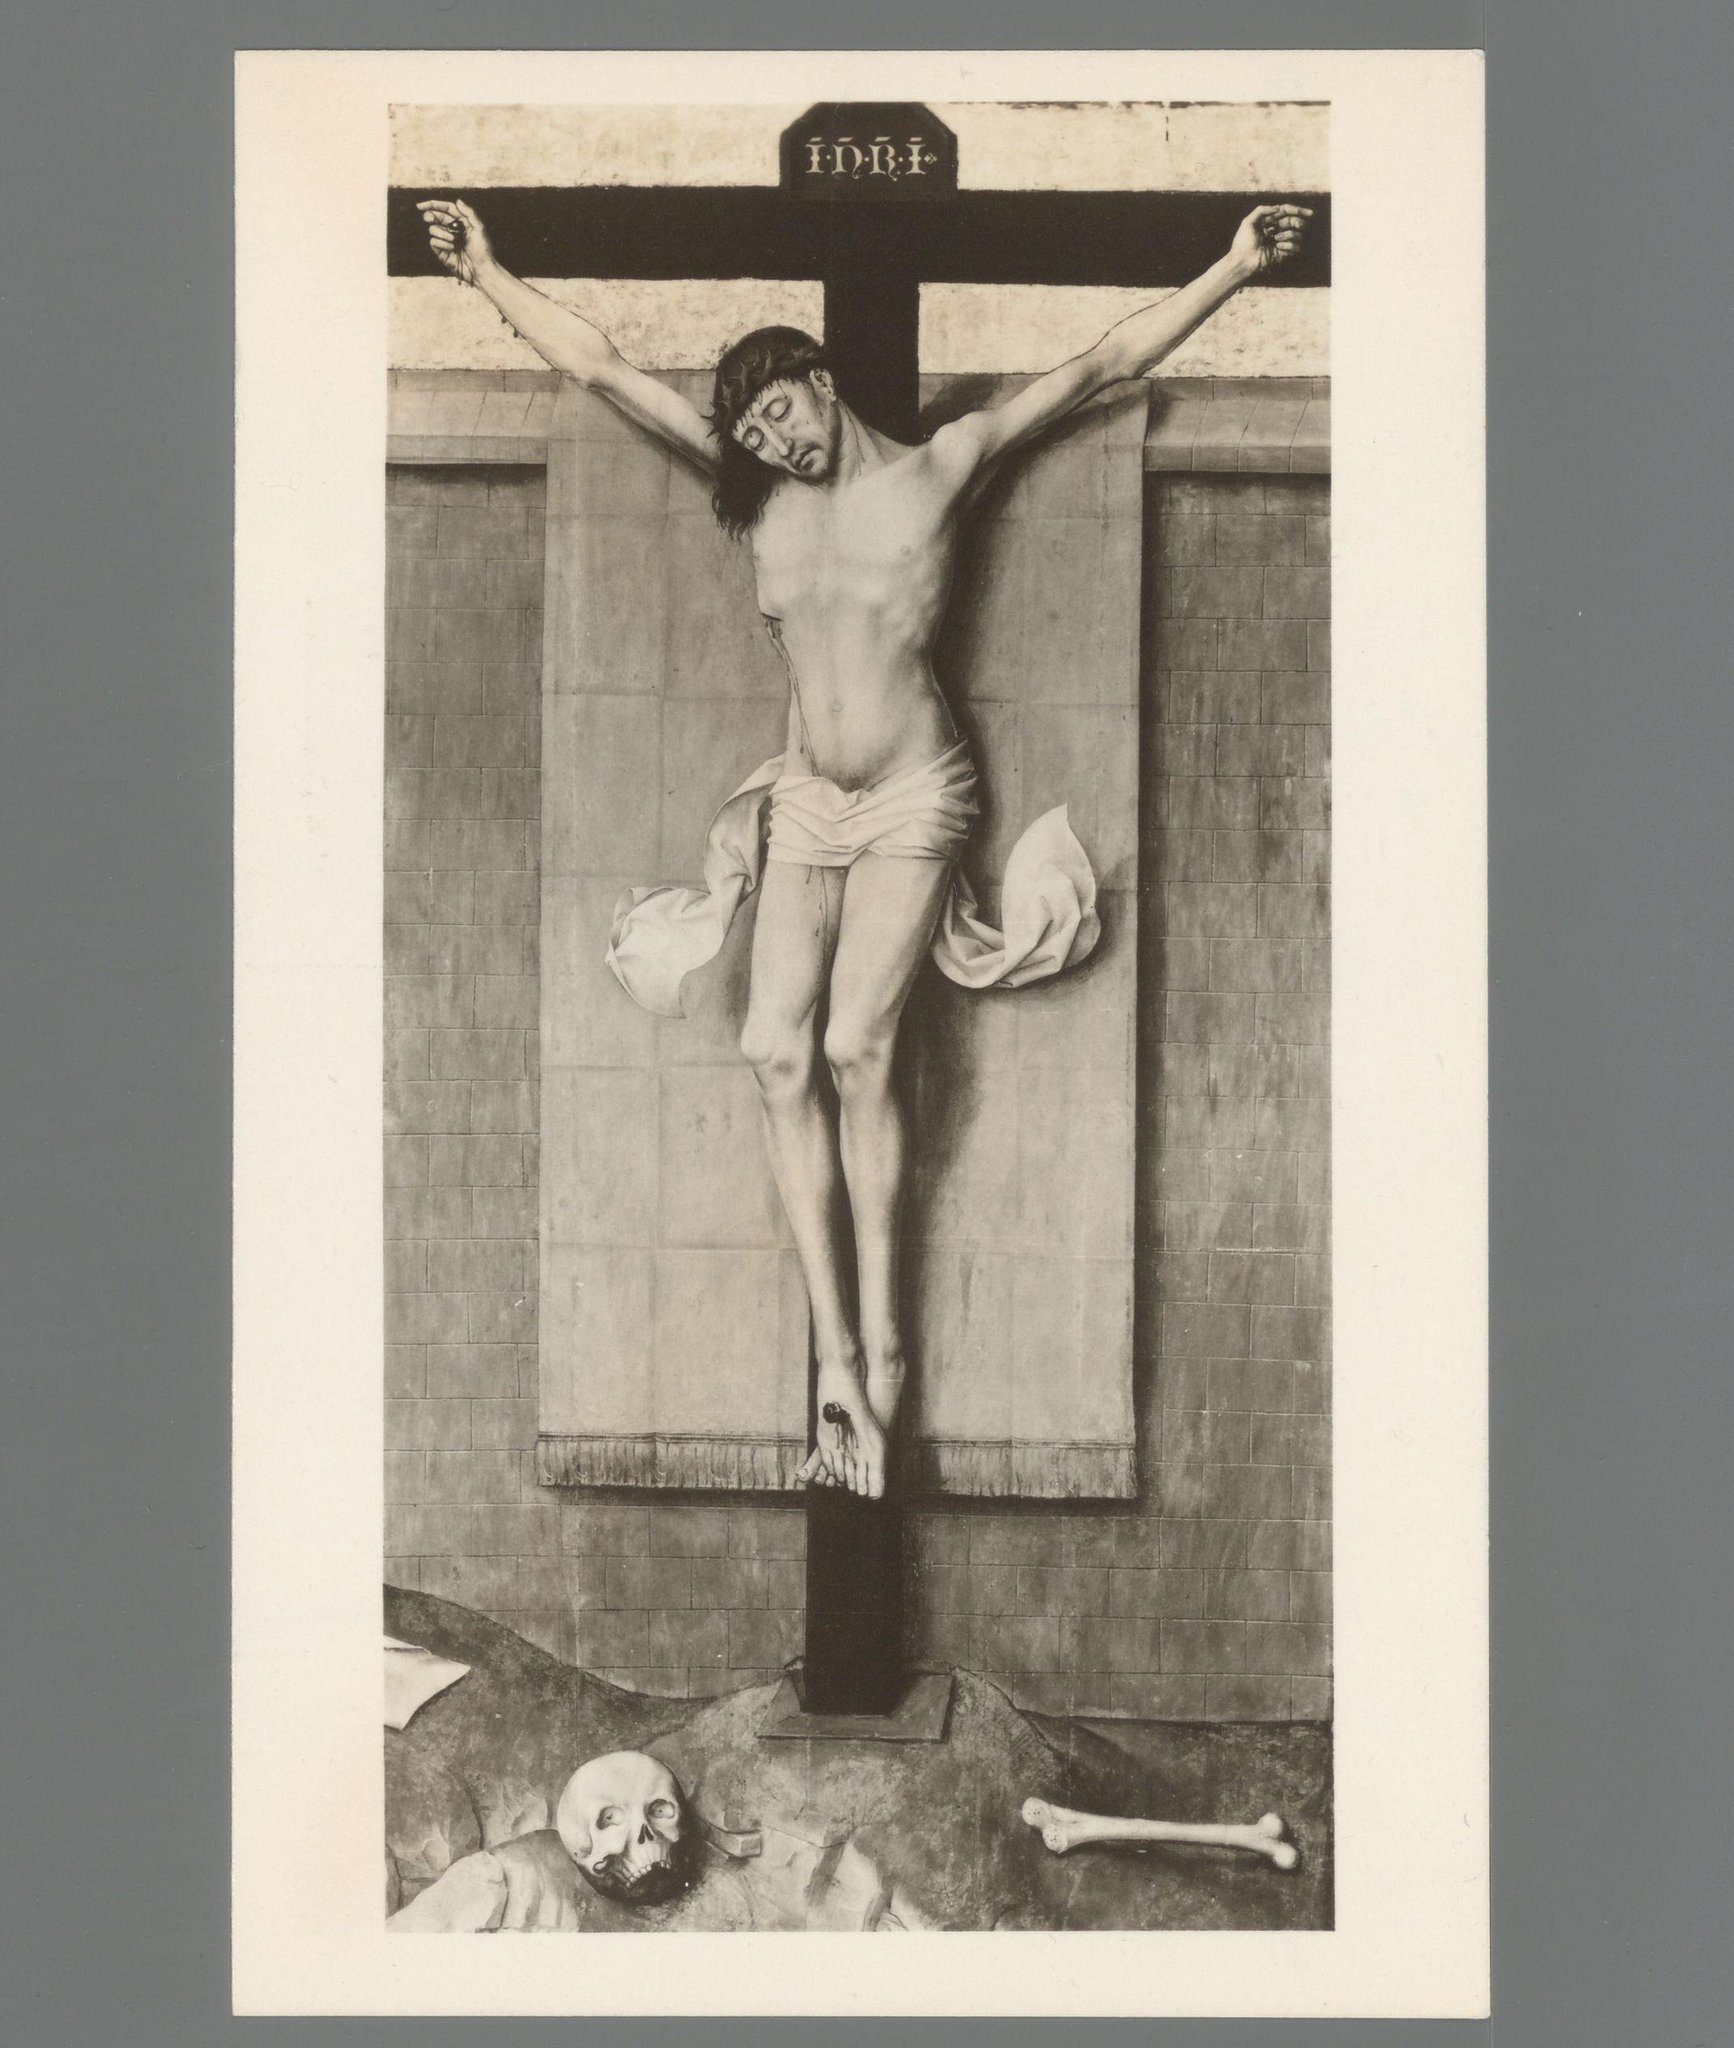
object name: ansichtkaart, prentbriefkaart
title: Christ on the Cross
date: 1920-1940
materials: photographic support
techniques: photography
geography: philadelphia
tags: the crucifixion of christ: christ's death on the cross; golgotha (matthew 27:45-58; mark 15:33-45; luke 23:44-52; john 19:25-38)